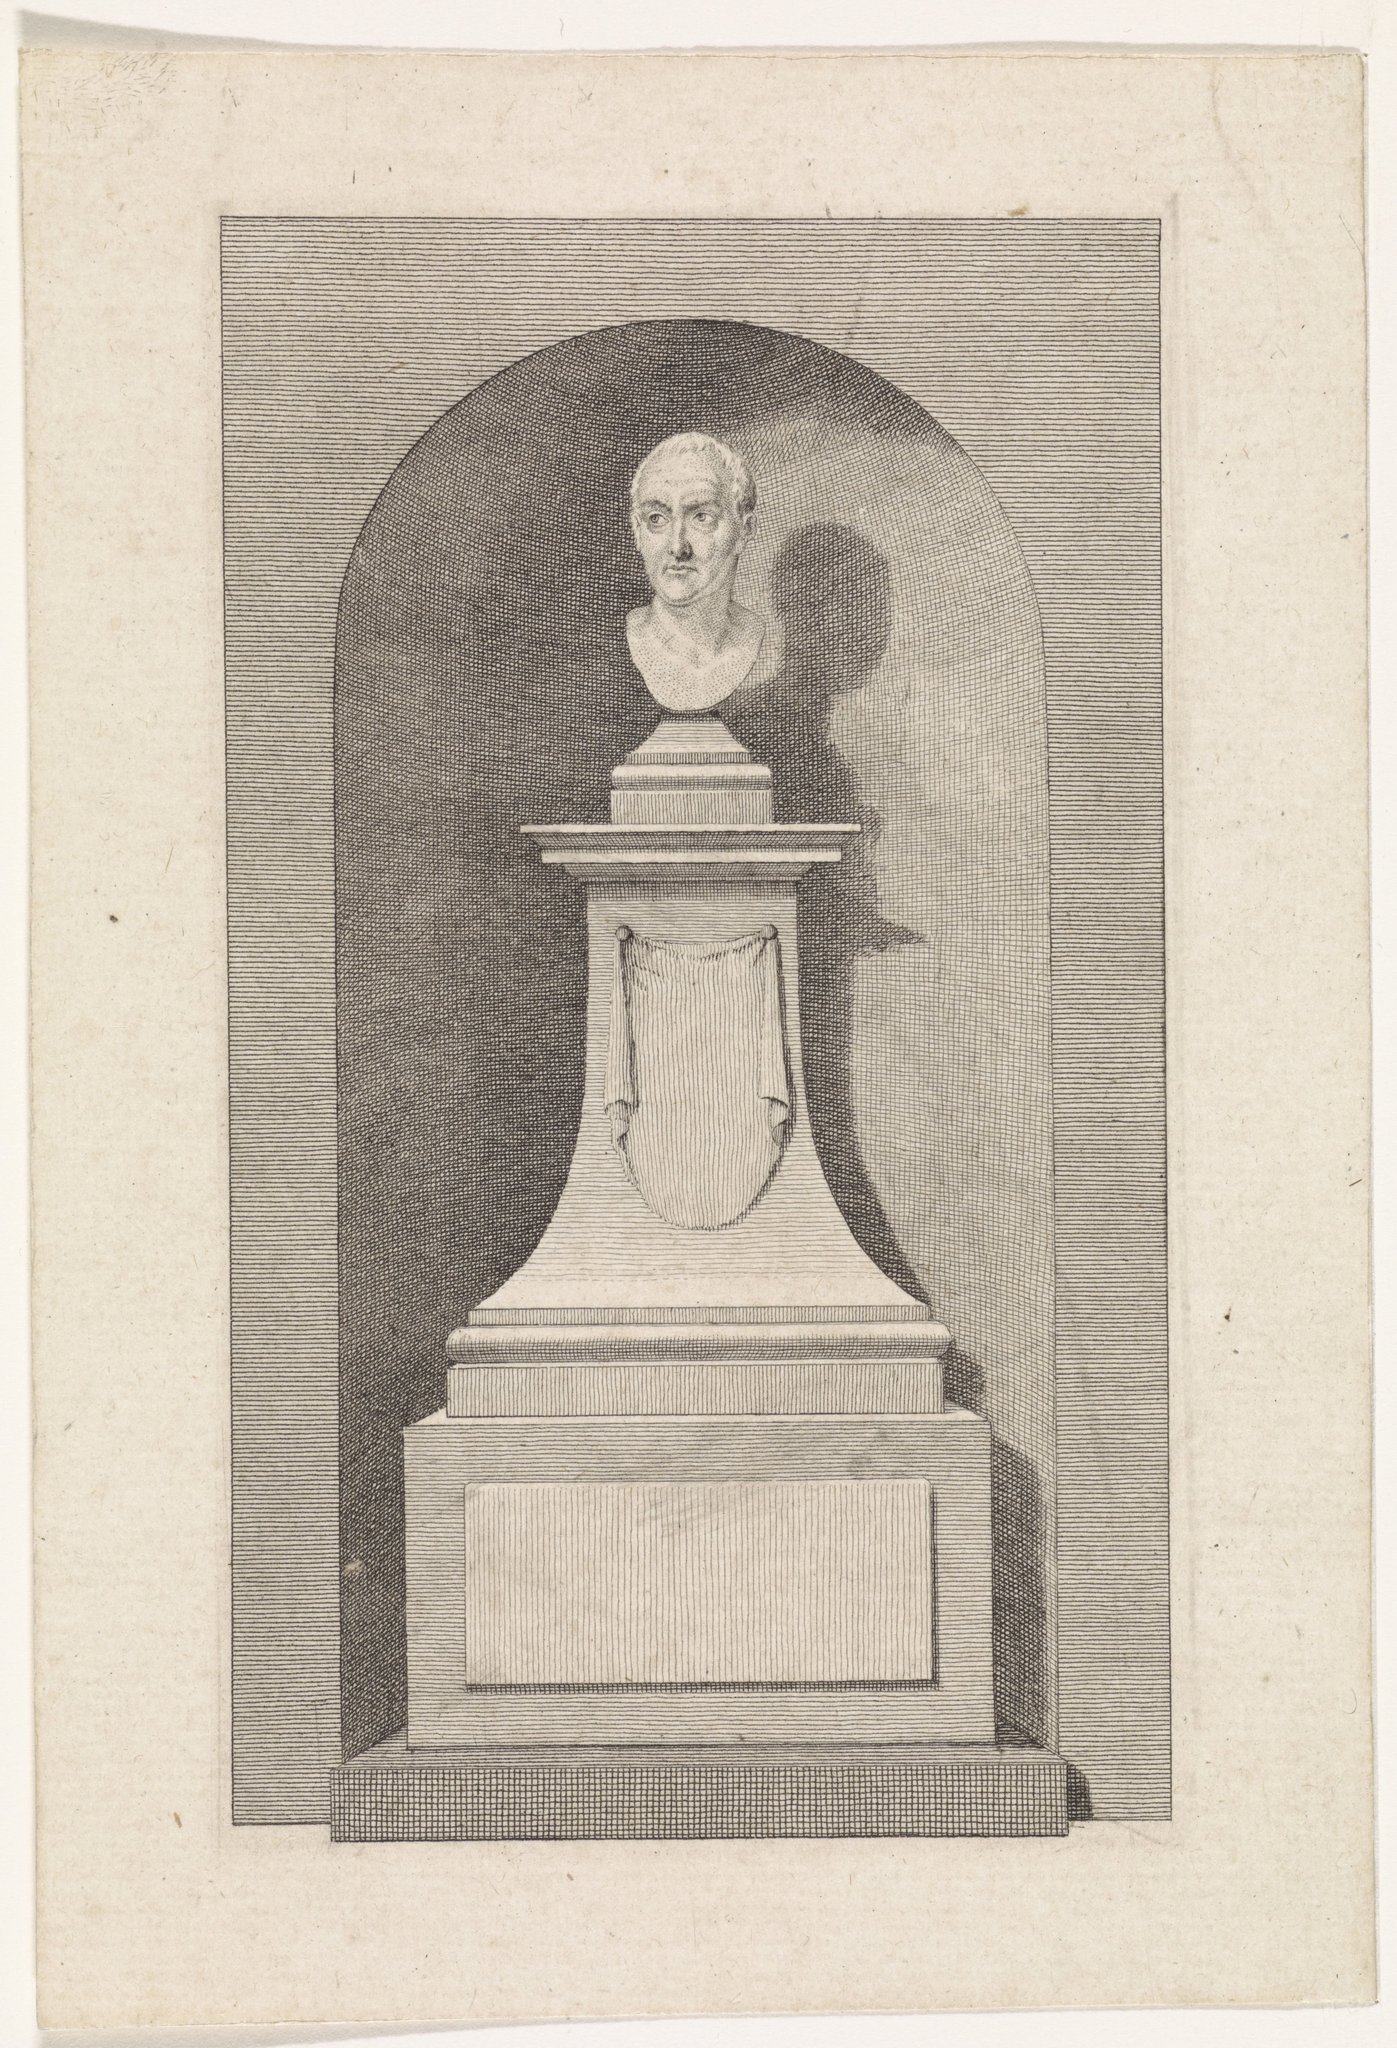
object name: print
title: Grafmonument voor Petrus Camper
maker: daniël vrijdag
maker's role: draughtsman, print maker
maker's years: 1765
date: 1792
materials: paper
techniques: engraving, etching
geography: amsterdam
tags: leiden, the hague, print maker, draughtsman, petrus camper, grave, tomb and other grave-forms and grave-markers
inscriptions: collector's mark: Lugt 2228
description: Nis met buste van Petrus Camper. Grafmonument in de Pieterskerk in Leiden.